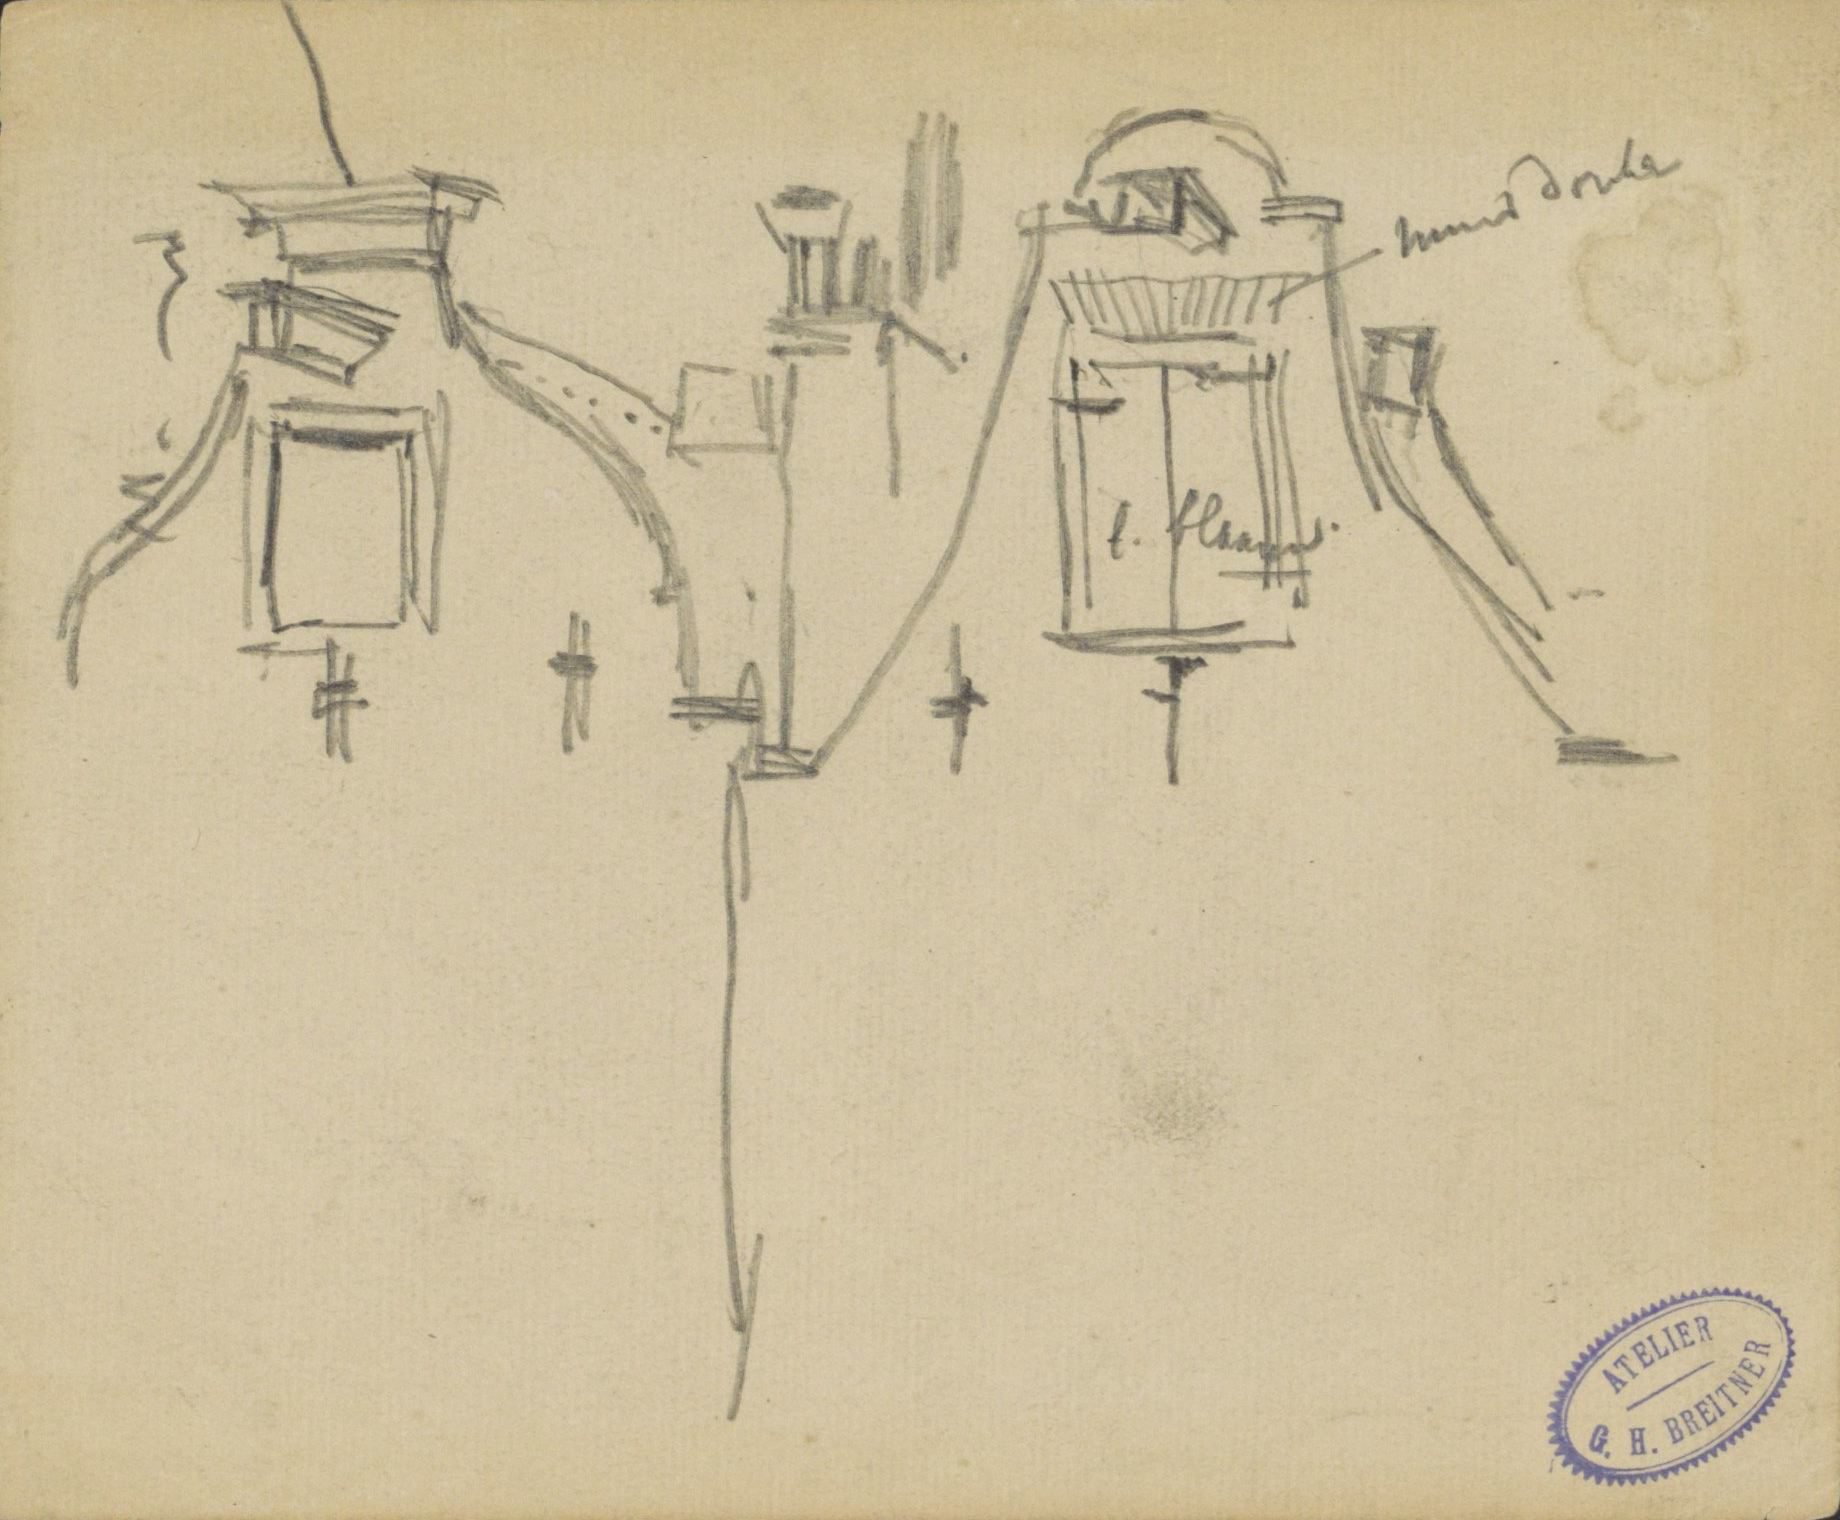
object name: drawing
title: Twee topgevels, waaronder een klokgevel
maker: george hendrik breitner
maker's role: draughtsman, painter, print maker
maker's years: 1857-1923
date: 1886-1923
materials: paper, pencil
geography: amsterdam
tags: façade (of house or building)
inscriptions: workshop stamp: Lugt 291d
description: Mogelijk in de Lijnbaanssteeg te Amsterdam.